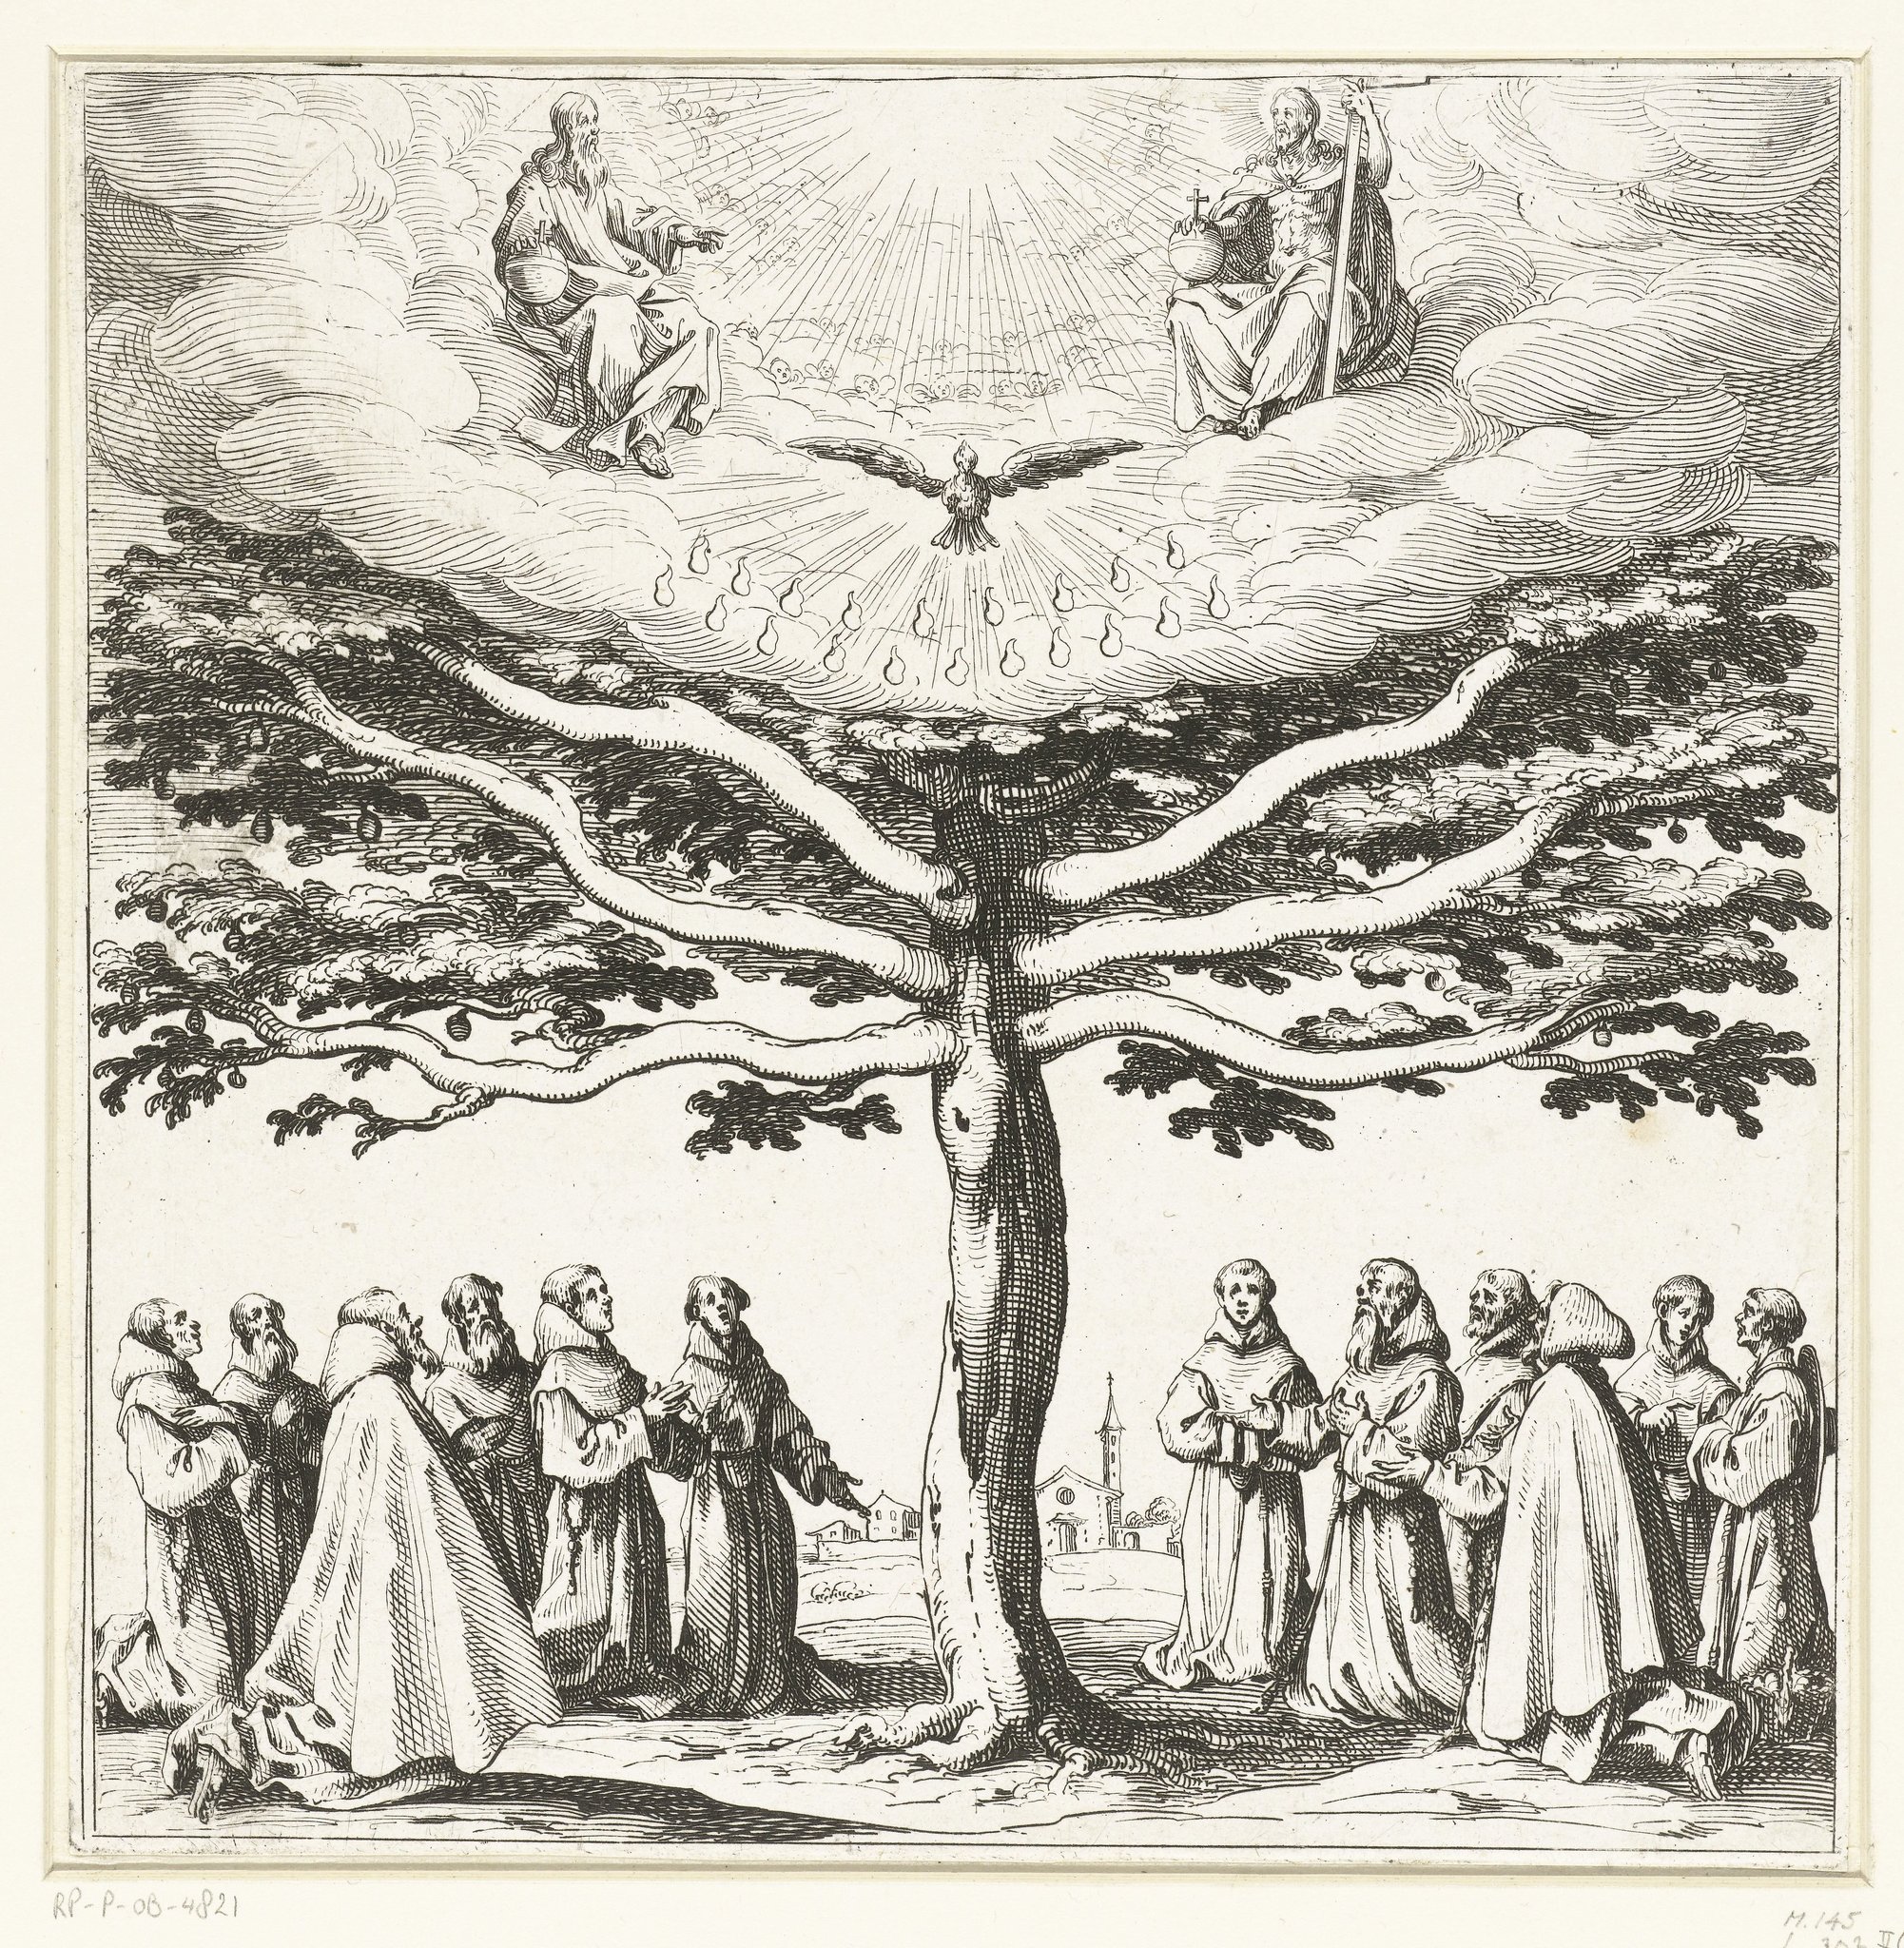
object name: print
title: De boom van de Heilige Franciscus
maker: jacques callot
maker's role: draughtsman, print maker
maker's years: 1592-1635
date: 1621-1625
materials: paper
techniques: etching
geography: nancy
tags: trees, the holy trinity, 'trinitas coelestis'; father, son and holy ghost ~ christian religion, monastic orders, monastic life: franciscans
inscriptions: collector's mark: Lugt 240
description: Twaalf Franciscaner monniken knielen onder een boom, waarboven de Heilige Drie-eenheid te zien is: God (links) met rijksappel, Christus (rechts) met kruis en rijksappel en de Heilige Geest in de gedaante van een duif. Op de achtergrond achter de boom zijn een kerk en wat huizen te zien.